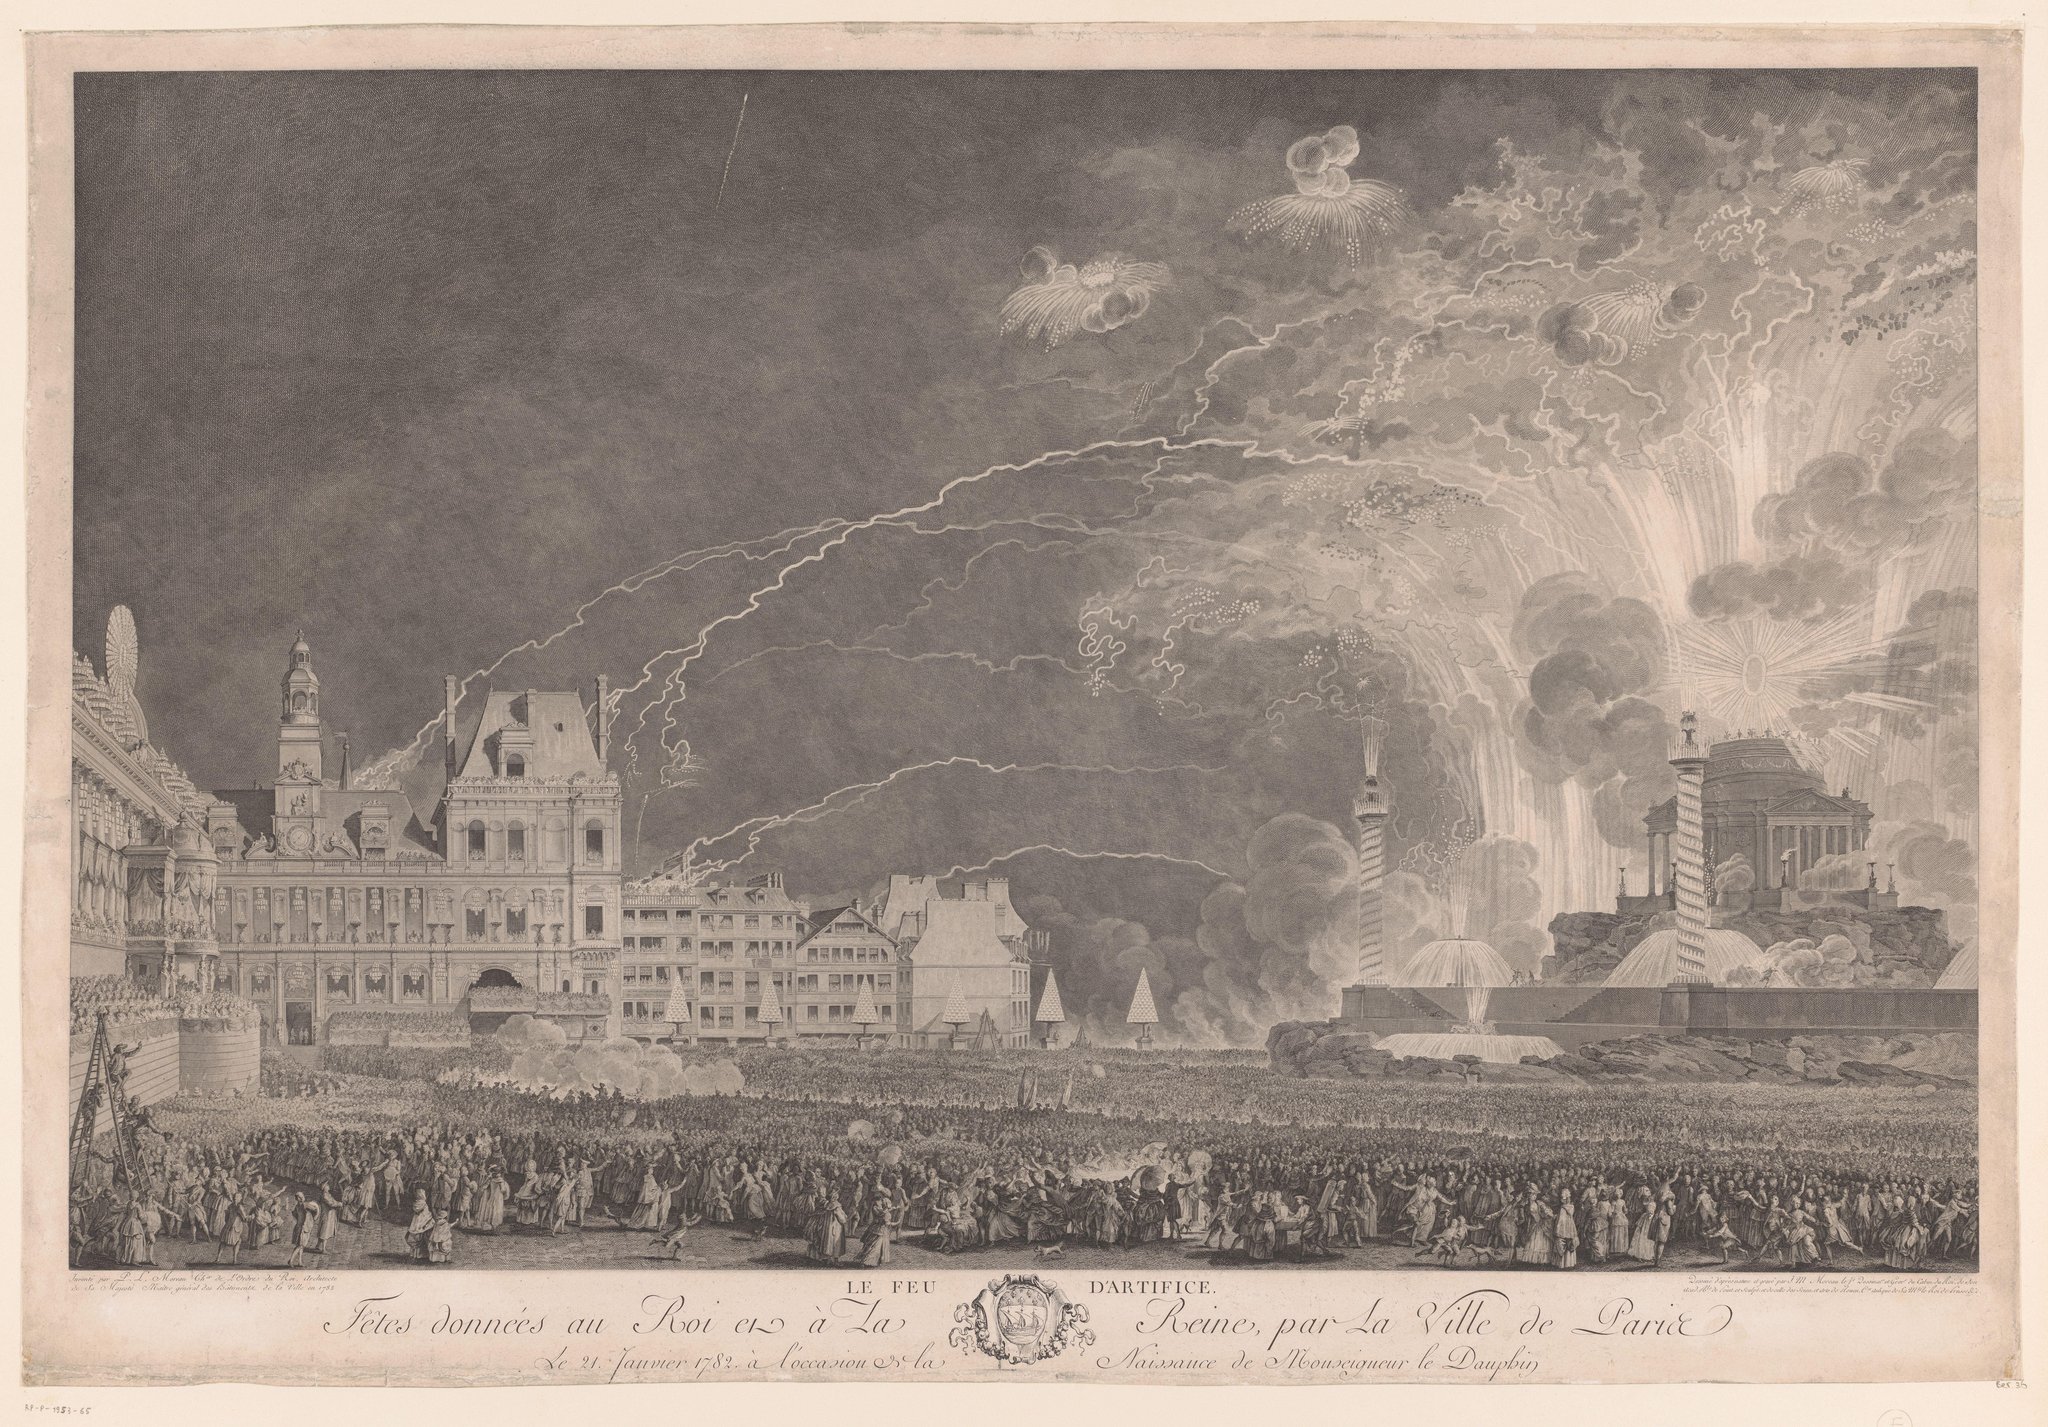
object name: print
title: Plein met vuurwerk ter ere van de geboorte van de dauphin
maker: jean michel moreau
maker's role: draughtsman, print maker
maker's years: 1741-1814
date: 1782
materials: paper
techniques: engraving, etching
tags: crowd, mob, bonfire, fire-works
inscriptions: collector's mark: Lugt 2760, collector's mark: Lugt 2228